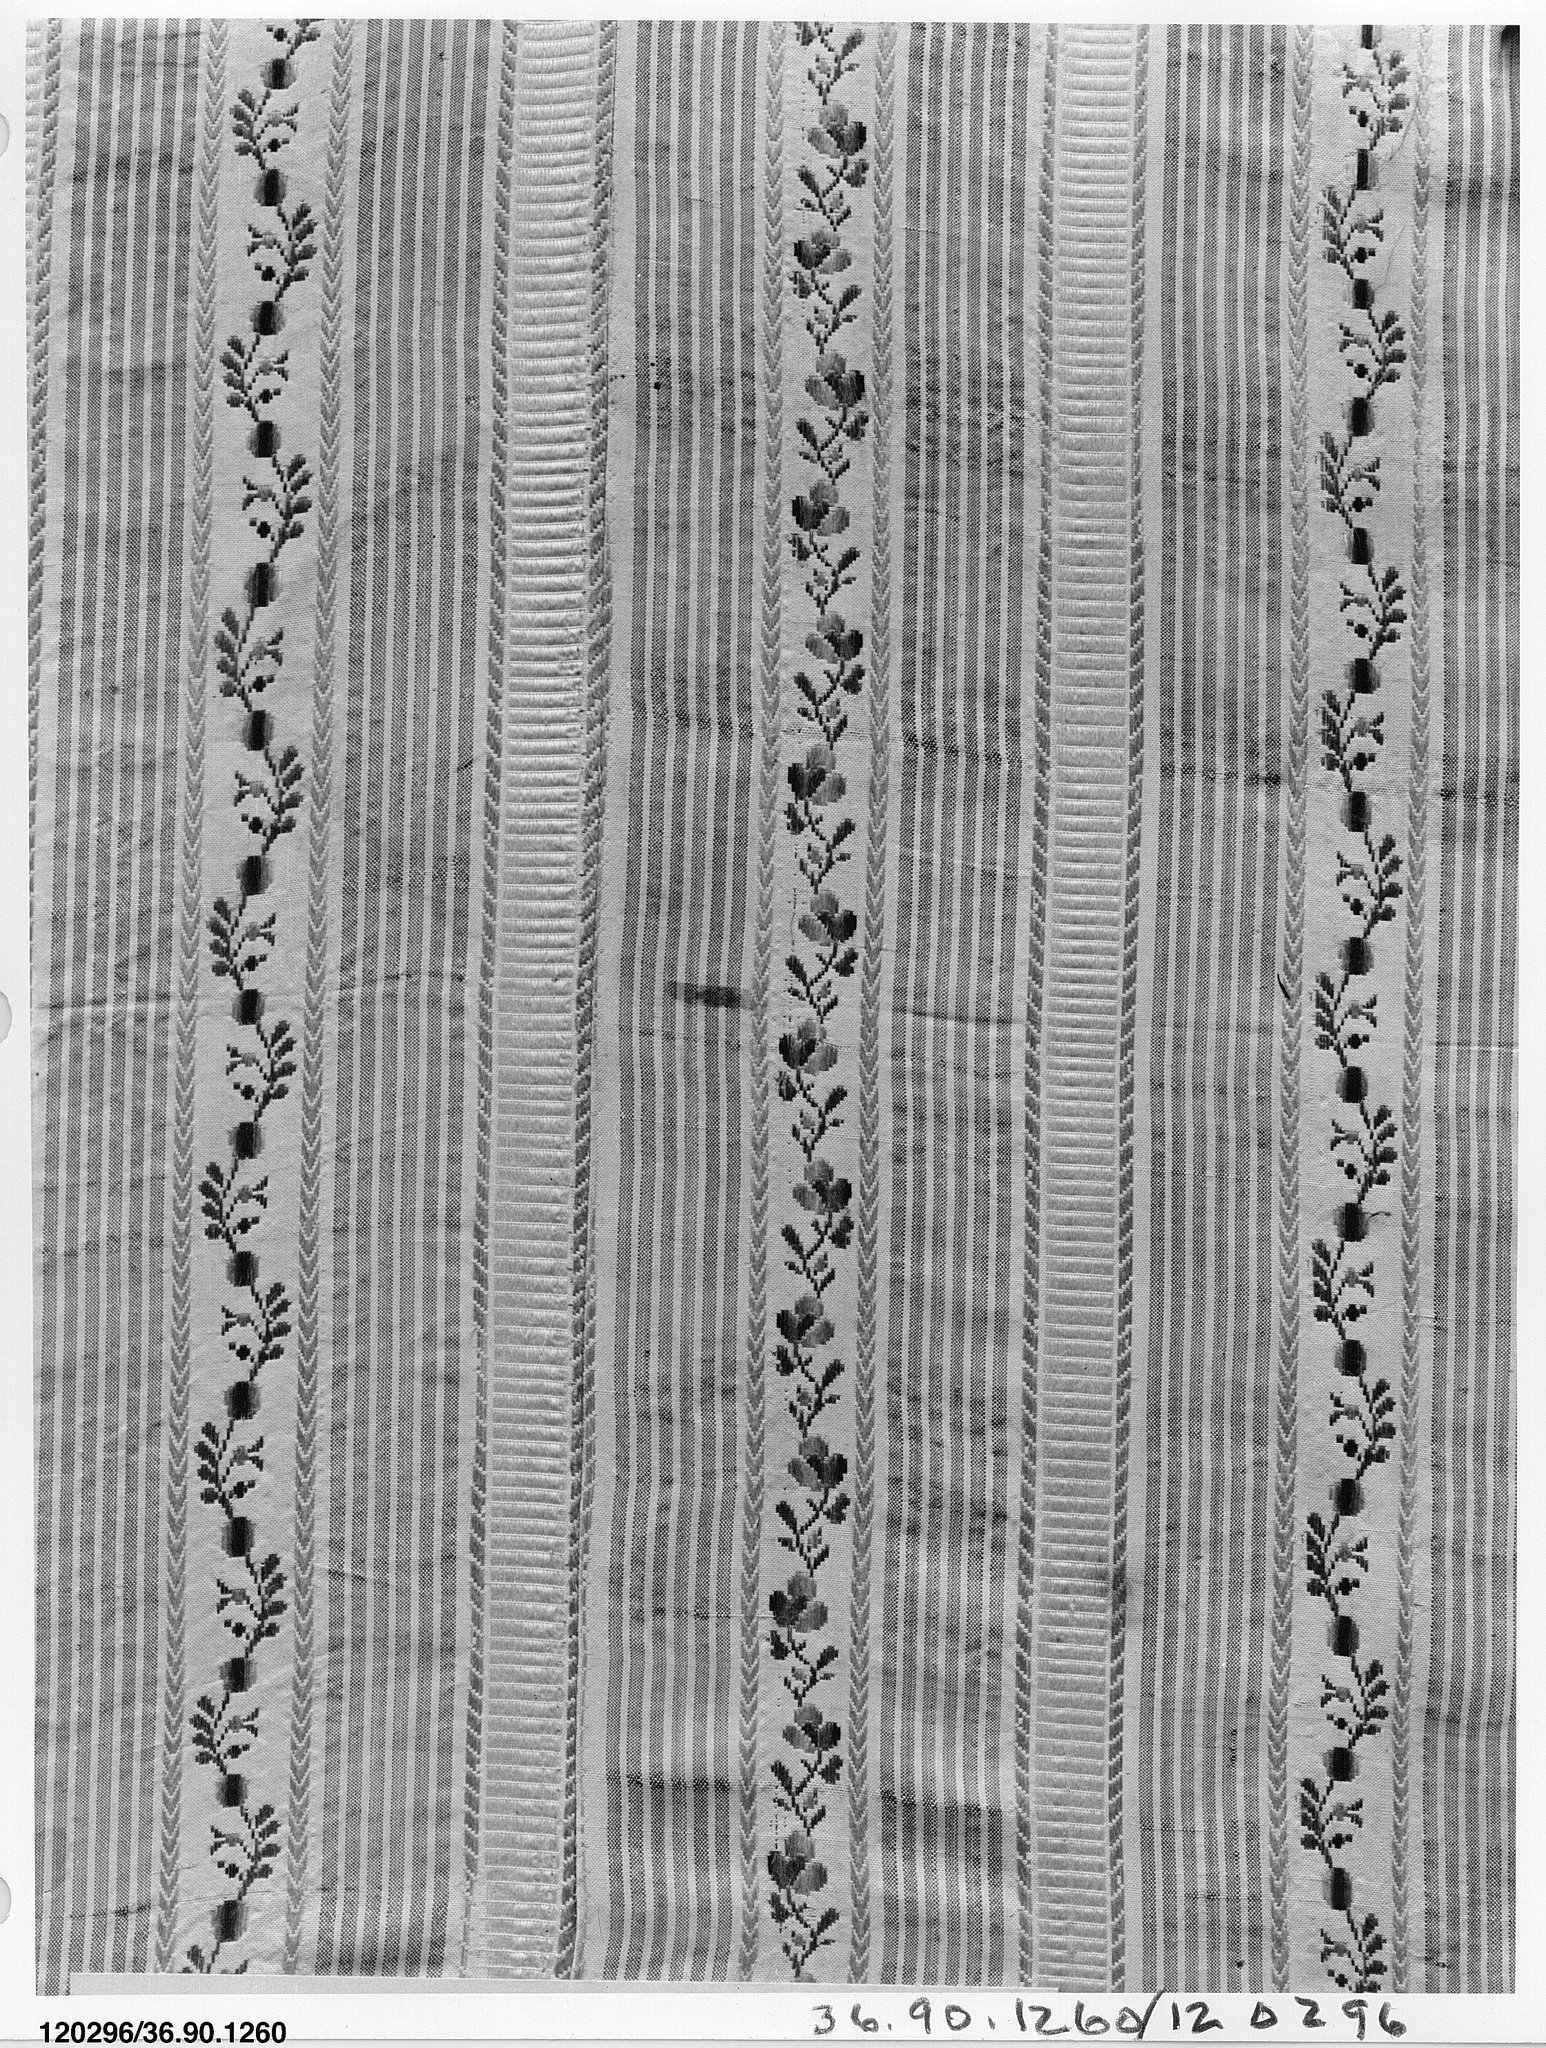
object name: piece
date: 1701-1800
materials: silk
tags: flowers,leaves